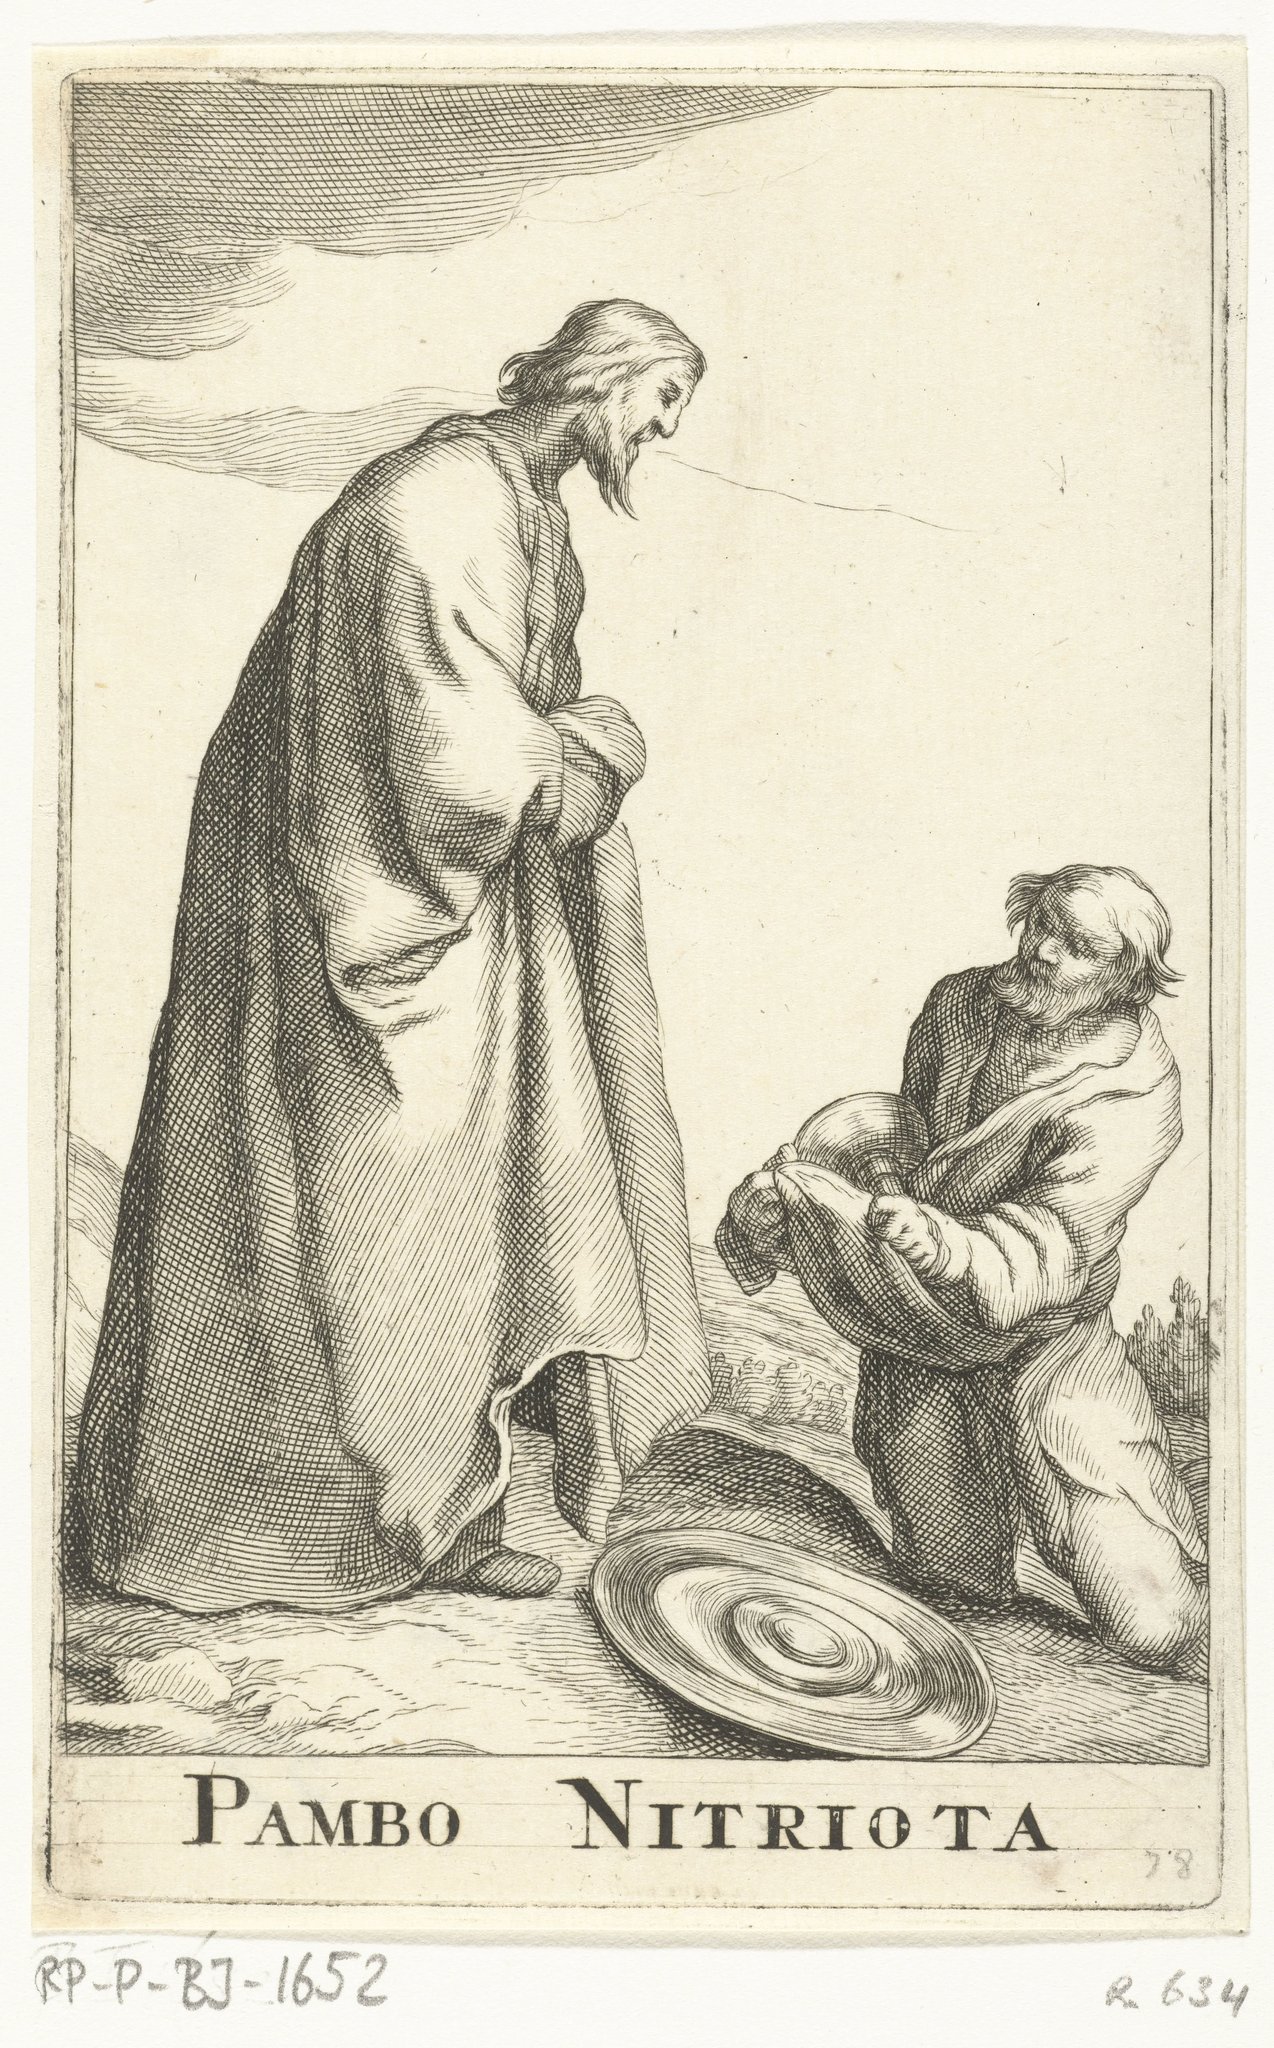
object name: print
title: Pambo Nitriota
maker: frederick bloemaert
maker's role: print maker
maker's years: 1614-1669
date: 1636-1670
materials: paper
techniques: engraving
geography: utrecht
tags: male saints (with name), anchorite, hermit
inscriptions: collector's mark: Lugt 240, number: ‘78’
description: De heilige Pambo van Nitria geeft goud dat hij voor zijn klooster heeft ontvangen door aan de armen. Prent uit een serie van 80 prenten en een titelprent met kluizenaars uit de 2e tot de 6e eeuw.